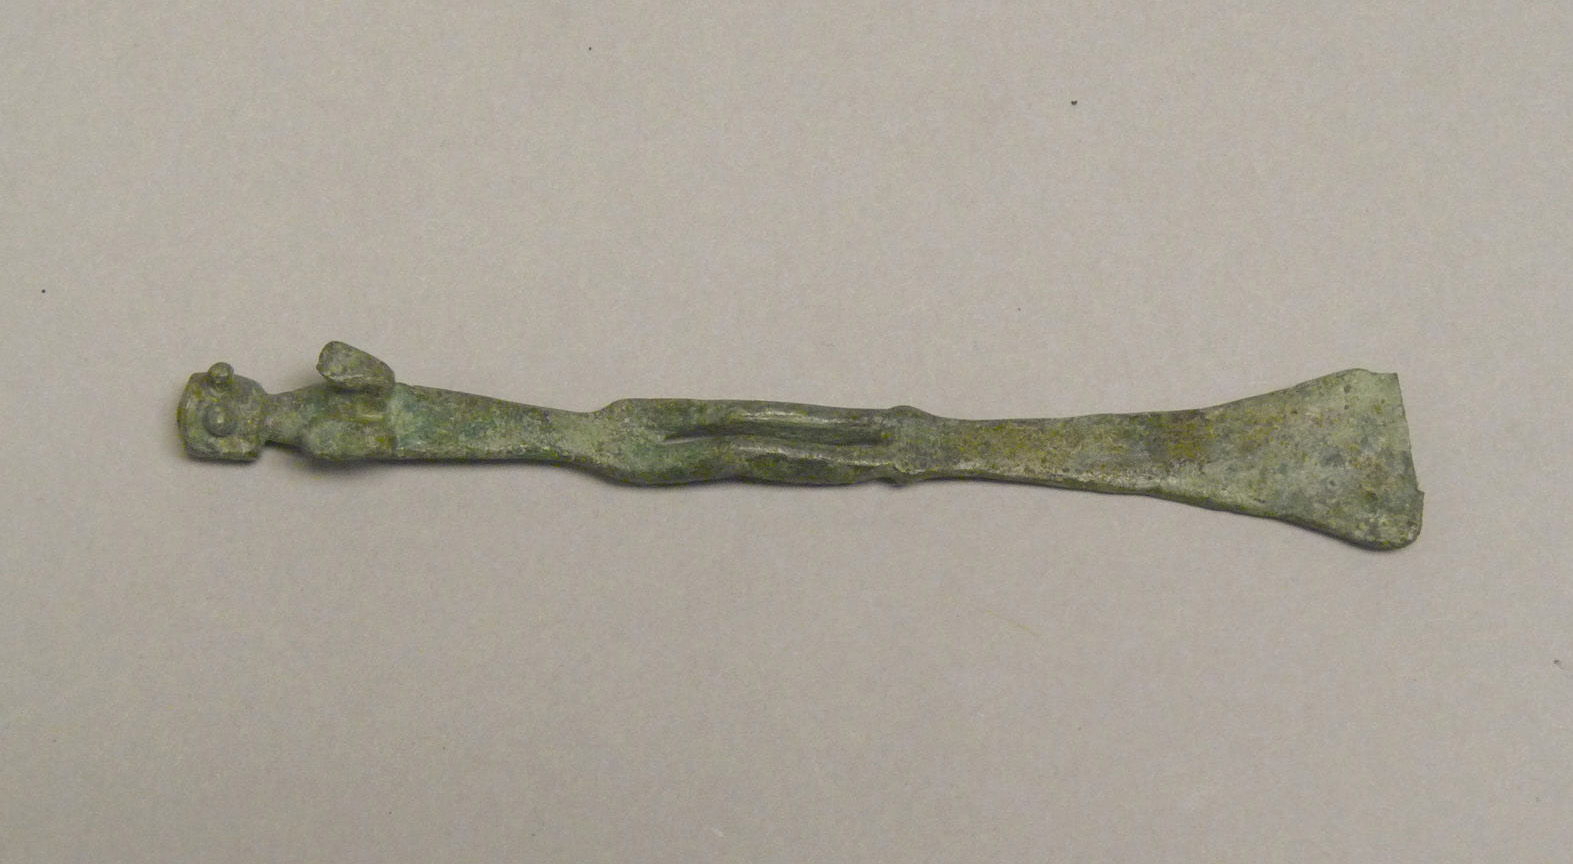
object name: lime spatula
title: Anthropomorphic Lime Spatula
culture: indonesian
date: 500 BCE-300 CE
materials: bronze